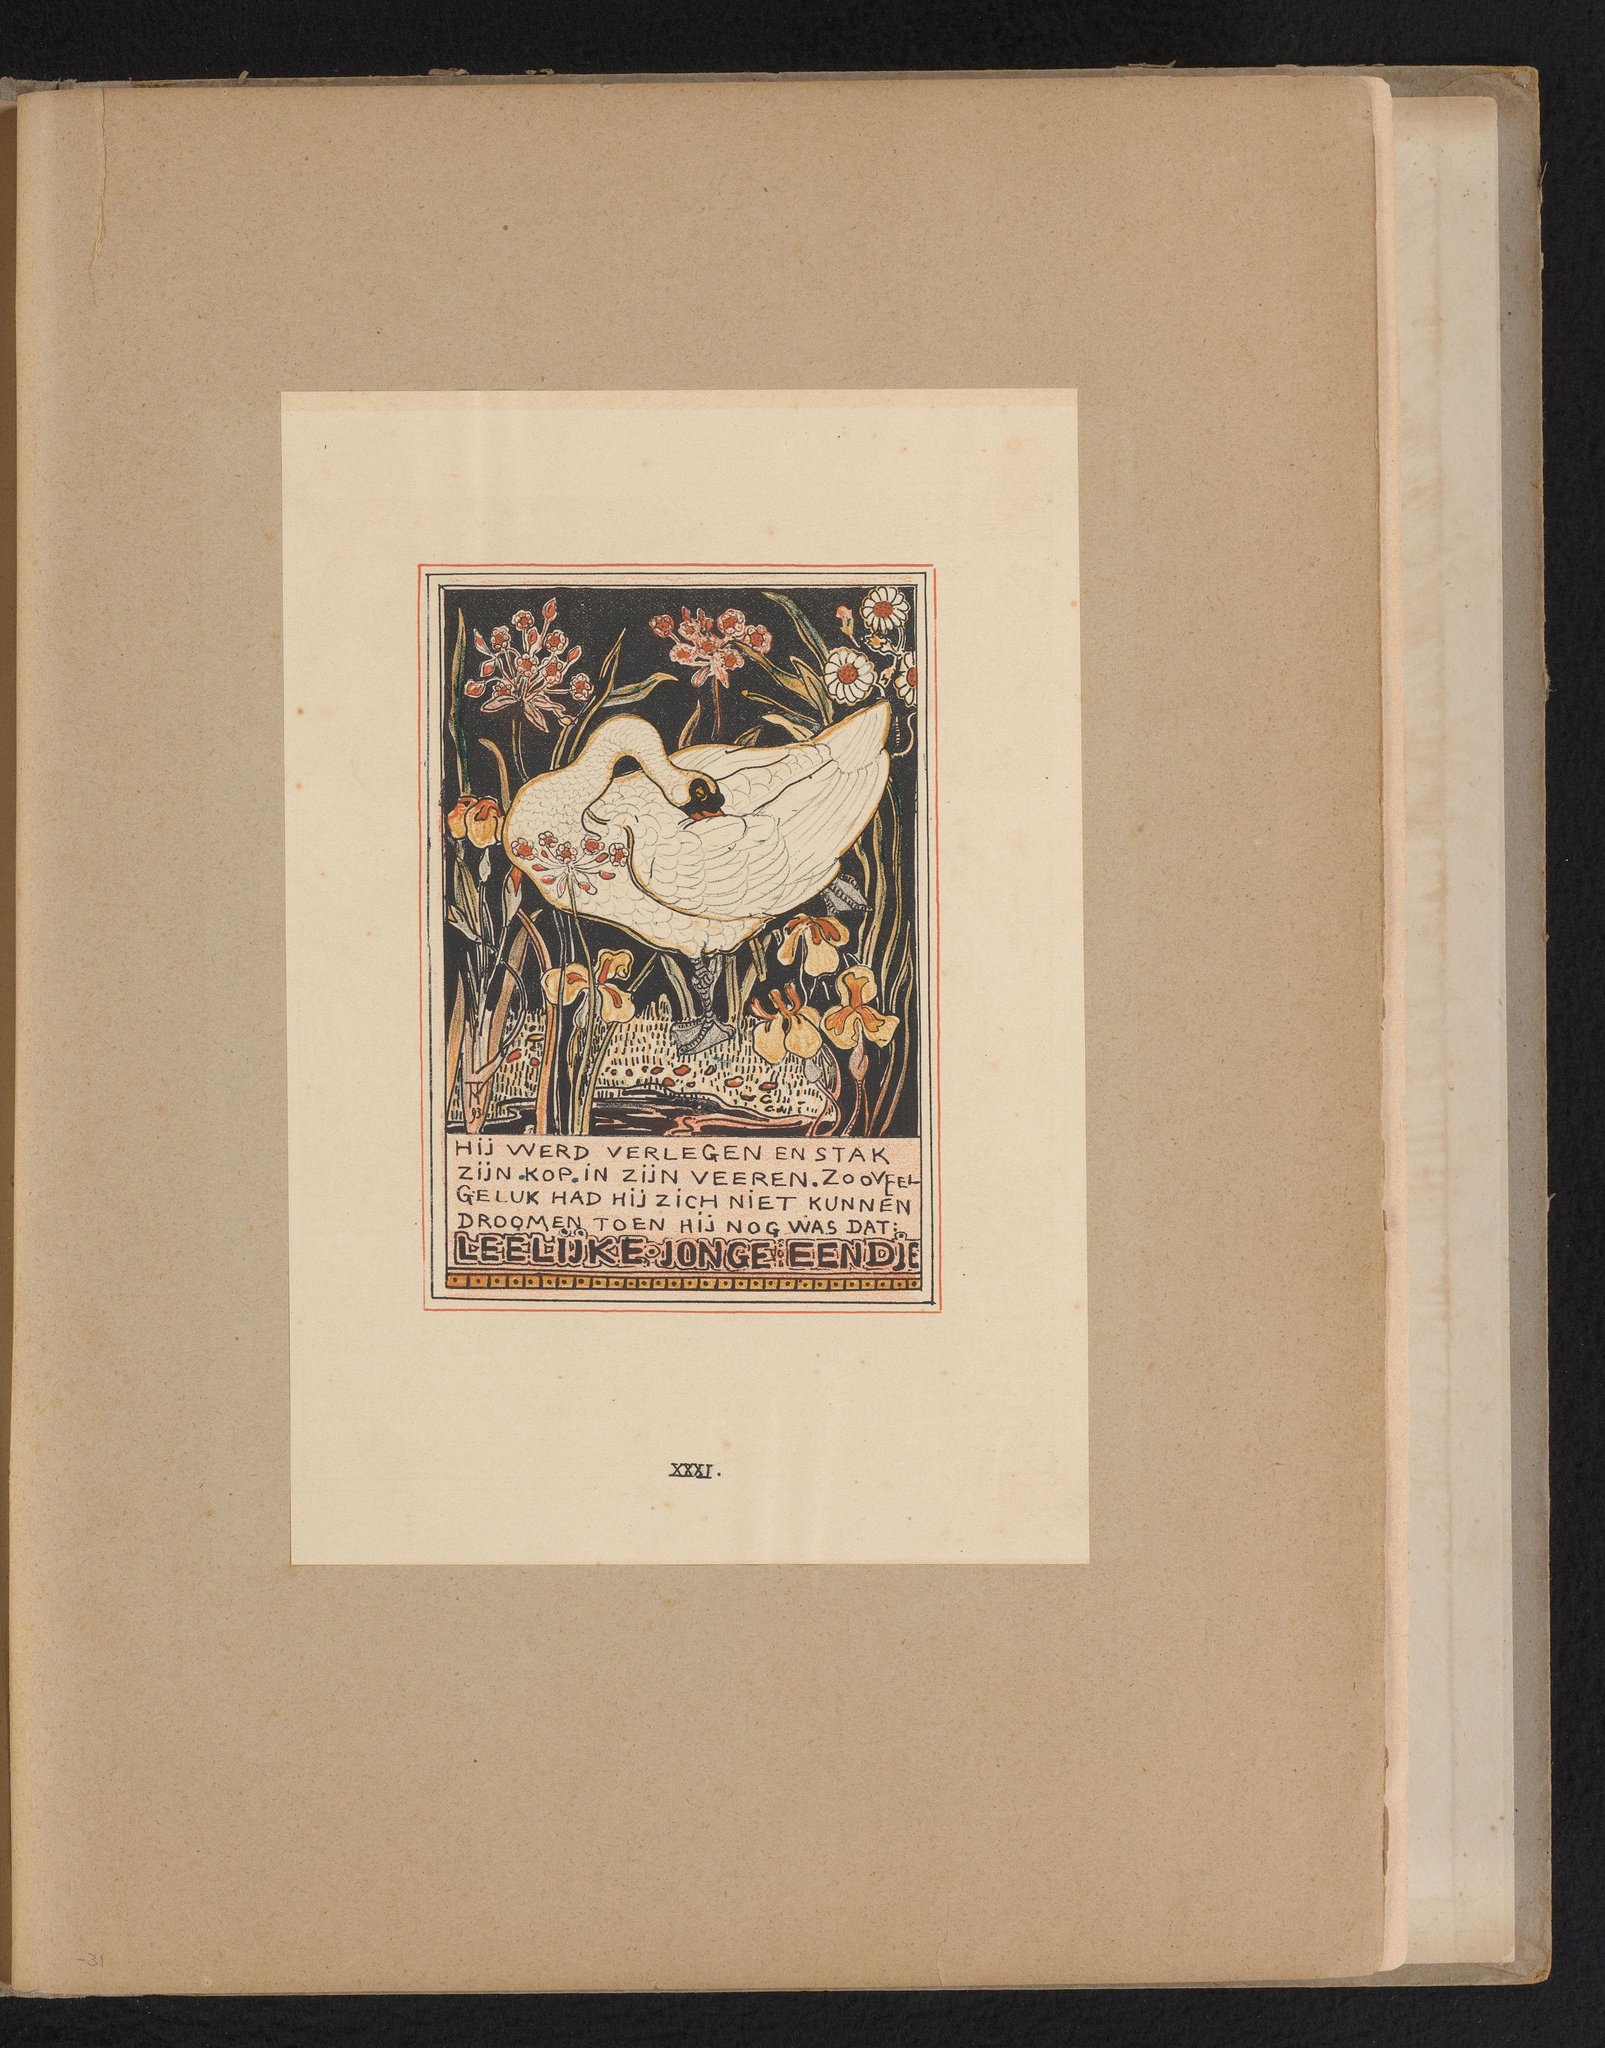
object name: album leaf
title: Het leelijke jonge eendje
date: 1893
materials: paper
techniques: lithograph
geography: the hague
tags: water-birds: swan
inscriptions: date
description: Deze prent maakt deel uit van een album.